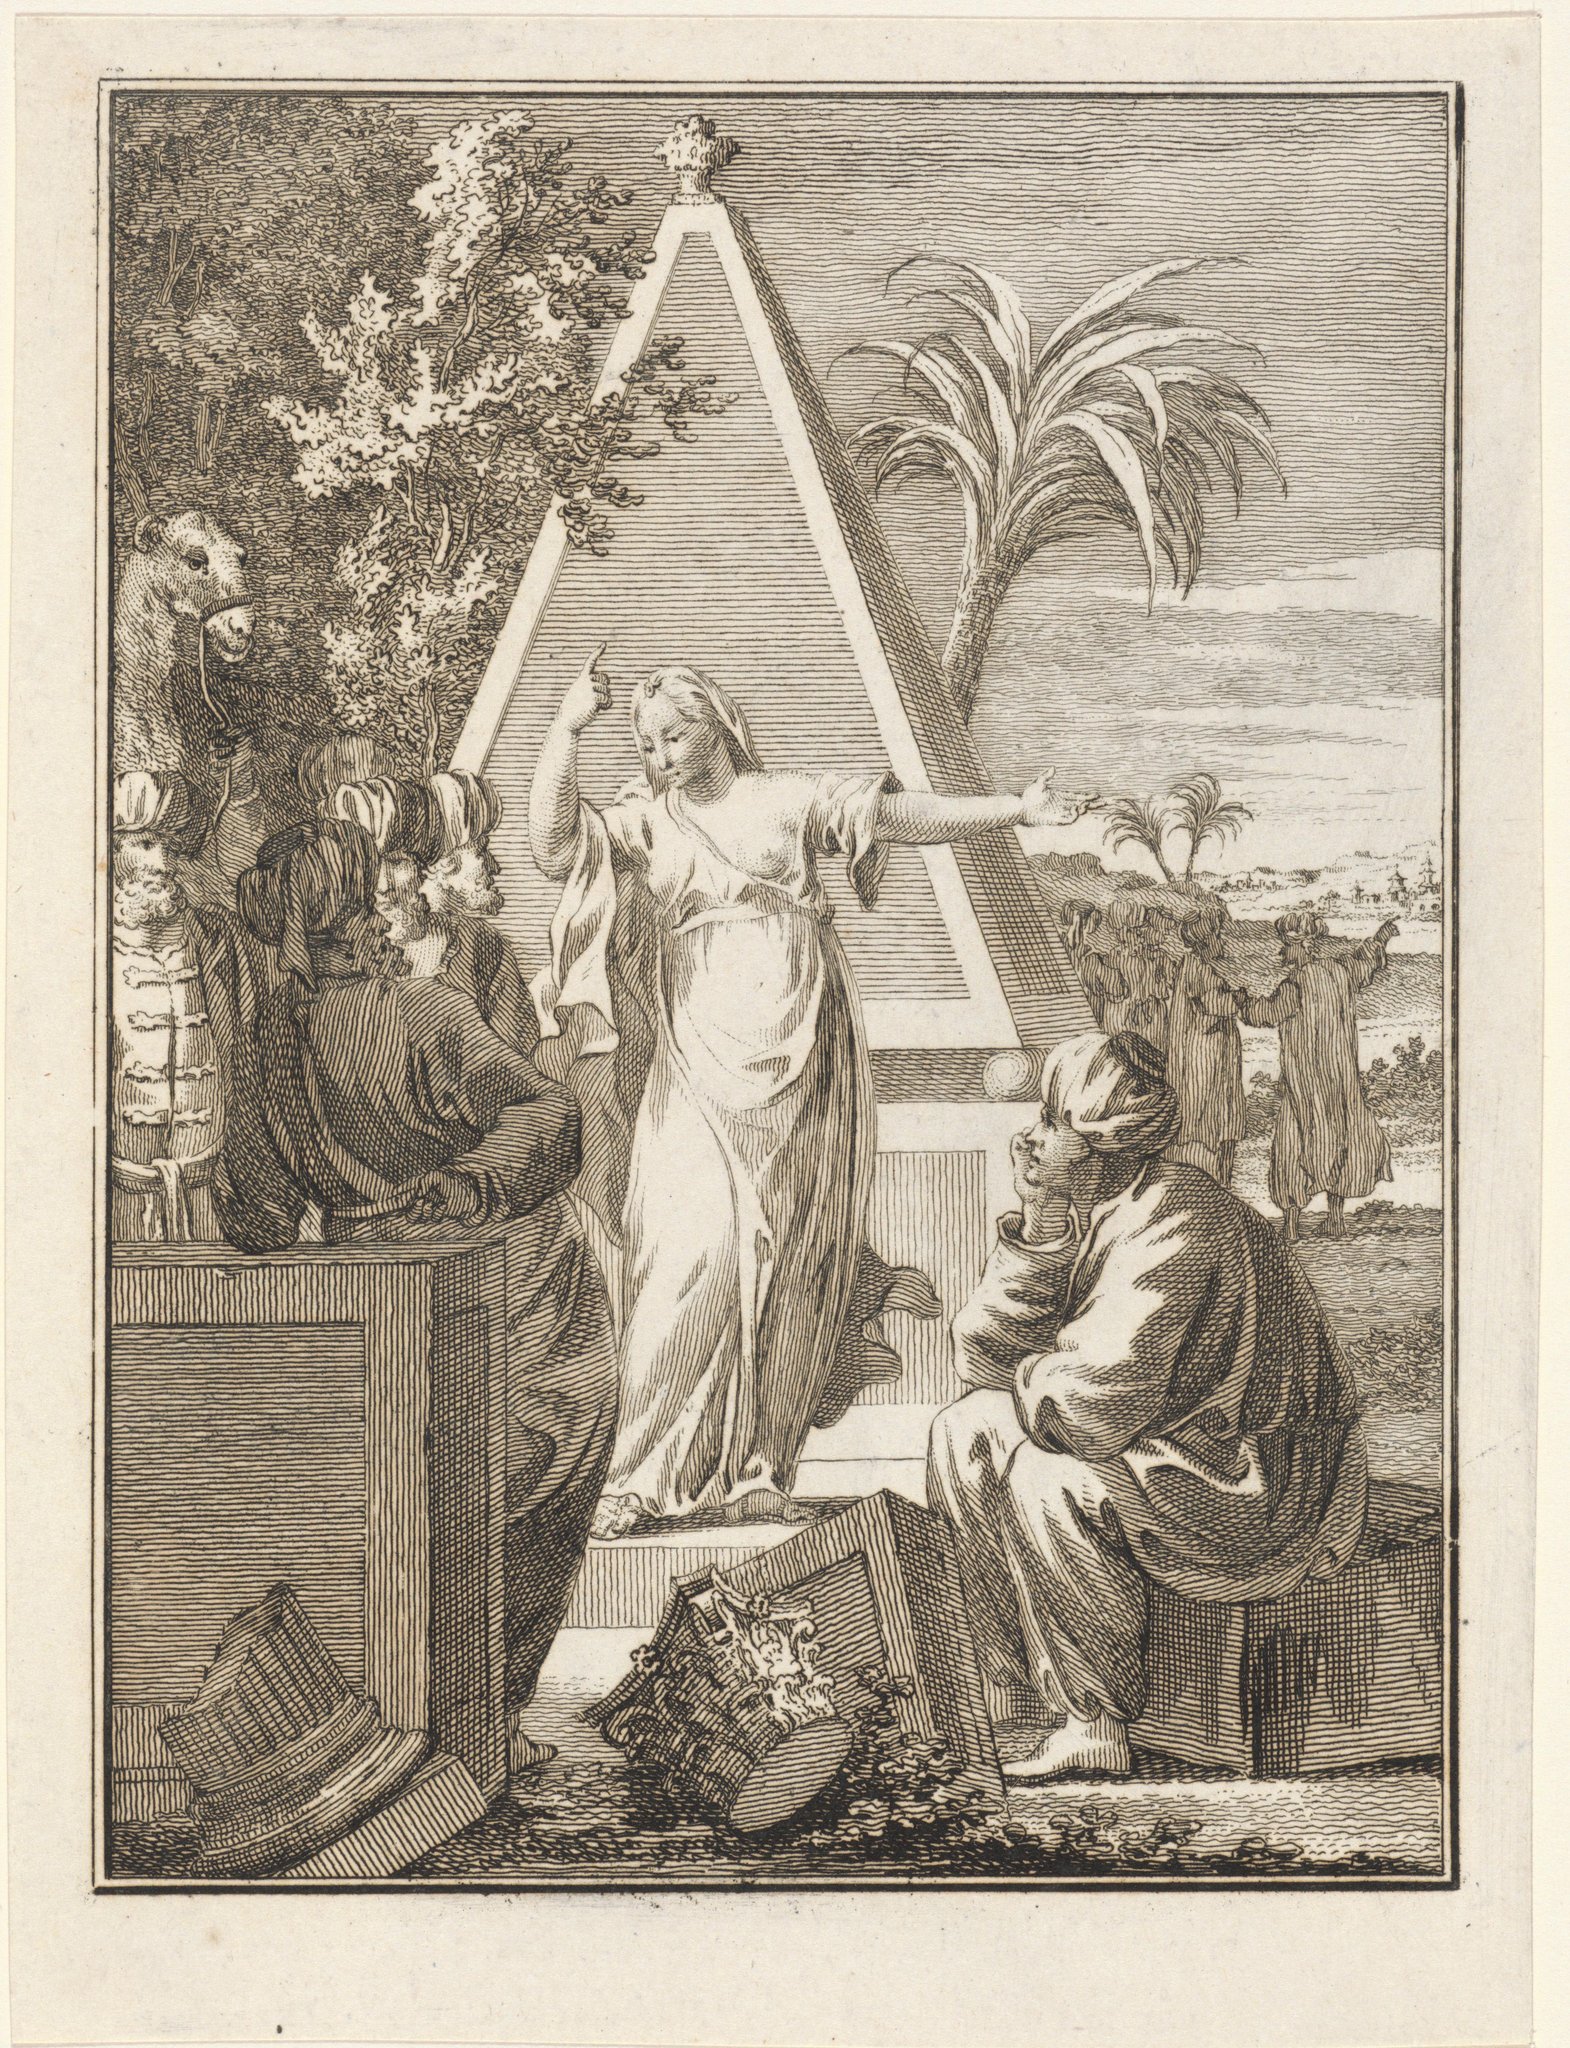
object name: print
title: Titelpagina voor: 'Hedendaagsche Historie der Turken, deel 4', 1766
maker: reinier vinkeles (i)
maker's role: draughtsman, print maker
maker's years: 1741-1816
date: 1766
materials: paper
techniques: etching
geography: amsterdam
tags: asiatic races and peoples: turks, landscapes in tropical and sub-tropical regions, head-gear: turban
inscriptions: collector's mark: Lugt 2228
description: Proefdruk van titelpagina voor: Hedendaagsche historie; of Het vervolg van de Algemeene historie (...). IVde deel (...) behelzende de algemeene historie van de Turken. Amsterdam: Gerrit de Groot en Zoon en Petrus Schouten, Leiden: Pieter van der Eyk, 1766.